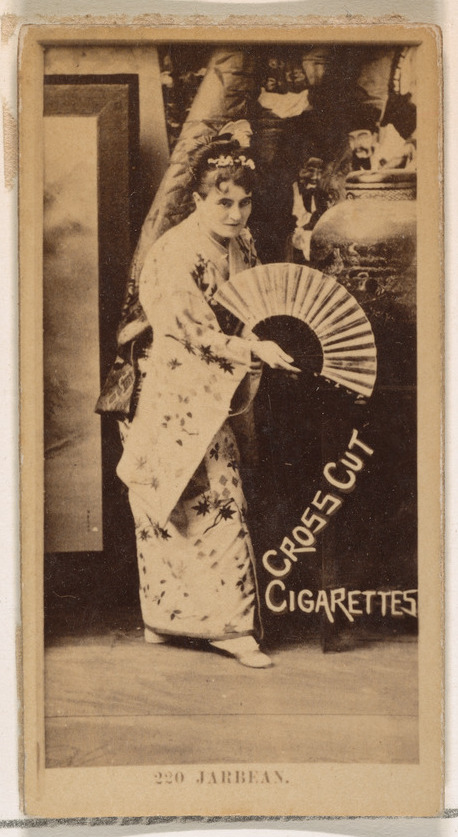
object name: print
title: Card Number 220, Miss Jarbeau, from the Actors and Actresses series (N145-2) issued by Duke Sons & Co. to promote Cross Cut Cigarettes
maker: w. duke, sons & co.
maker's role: publisher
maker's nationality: american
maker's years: 1870-1920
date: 1880-1889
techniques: albumen silver print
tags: portraits,women,actresses